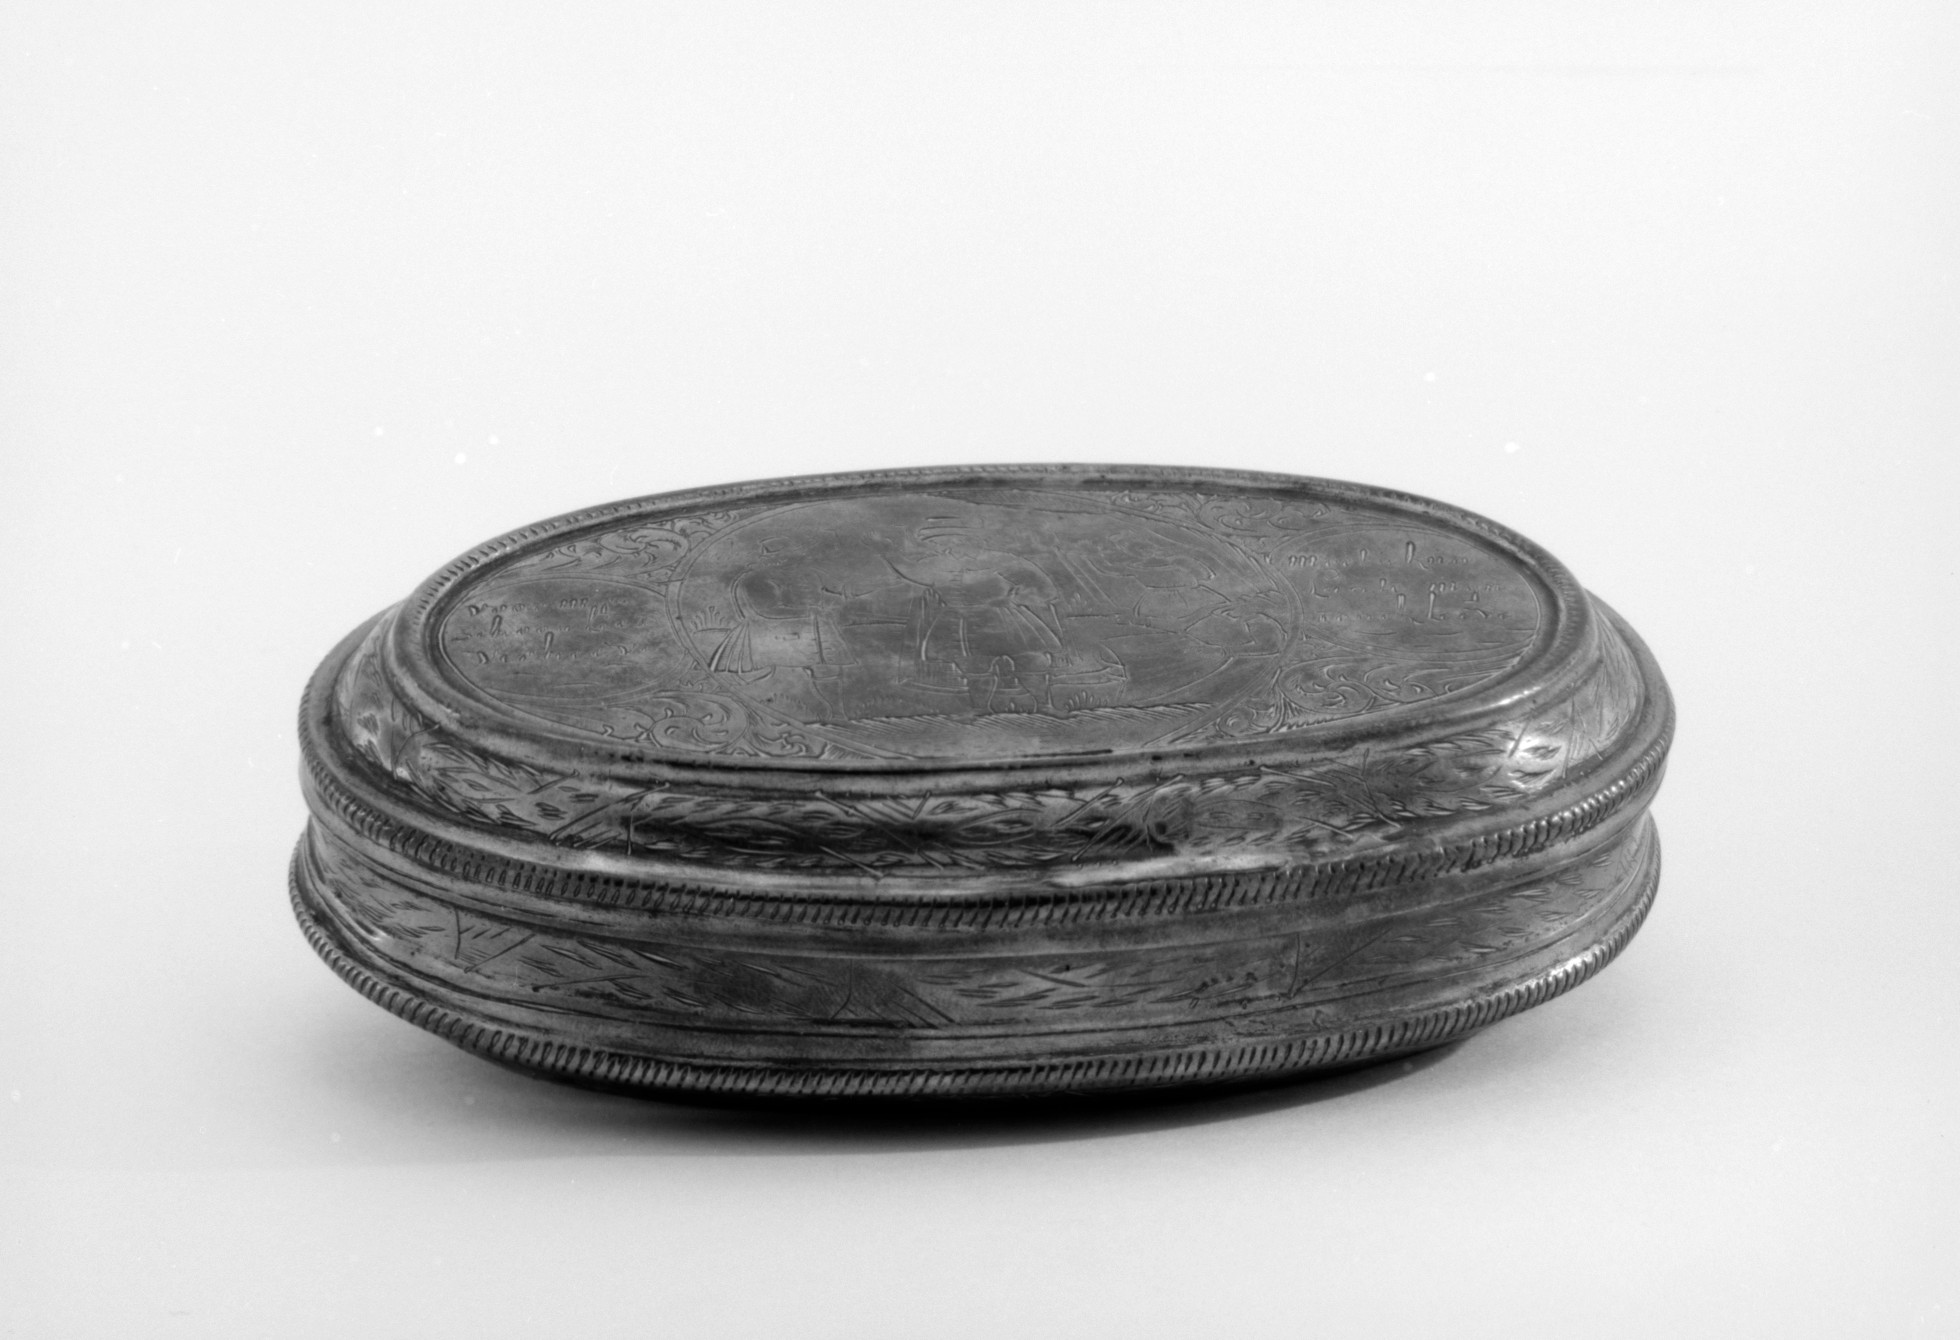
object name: tobacco box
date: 1701-1800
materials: copper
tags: swords,men,dogs